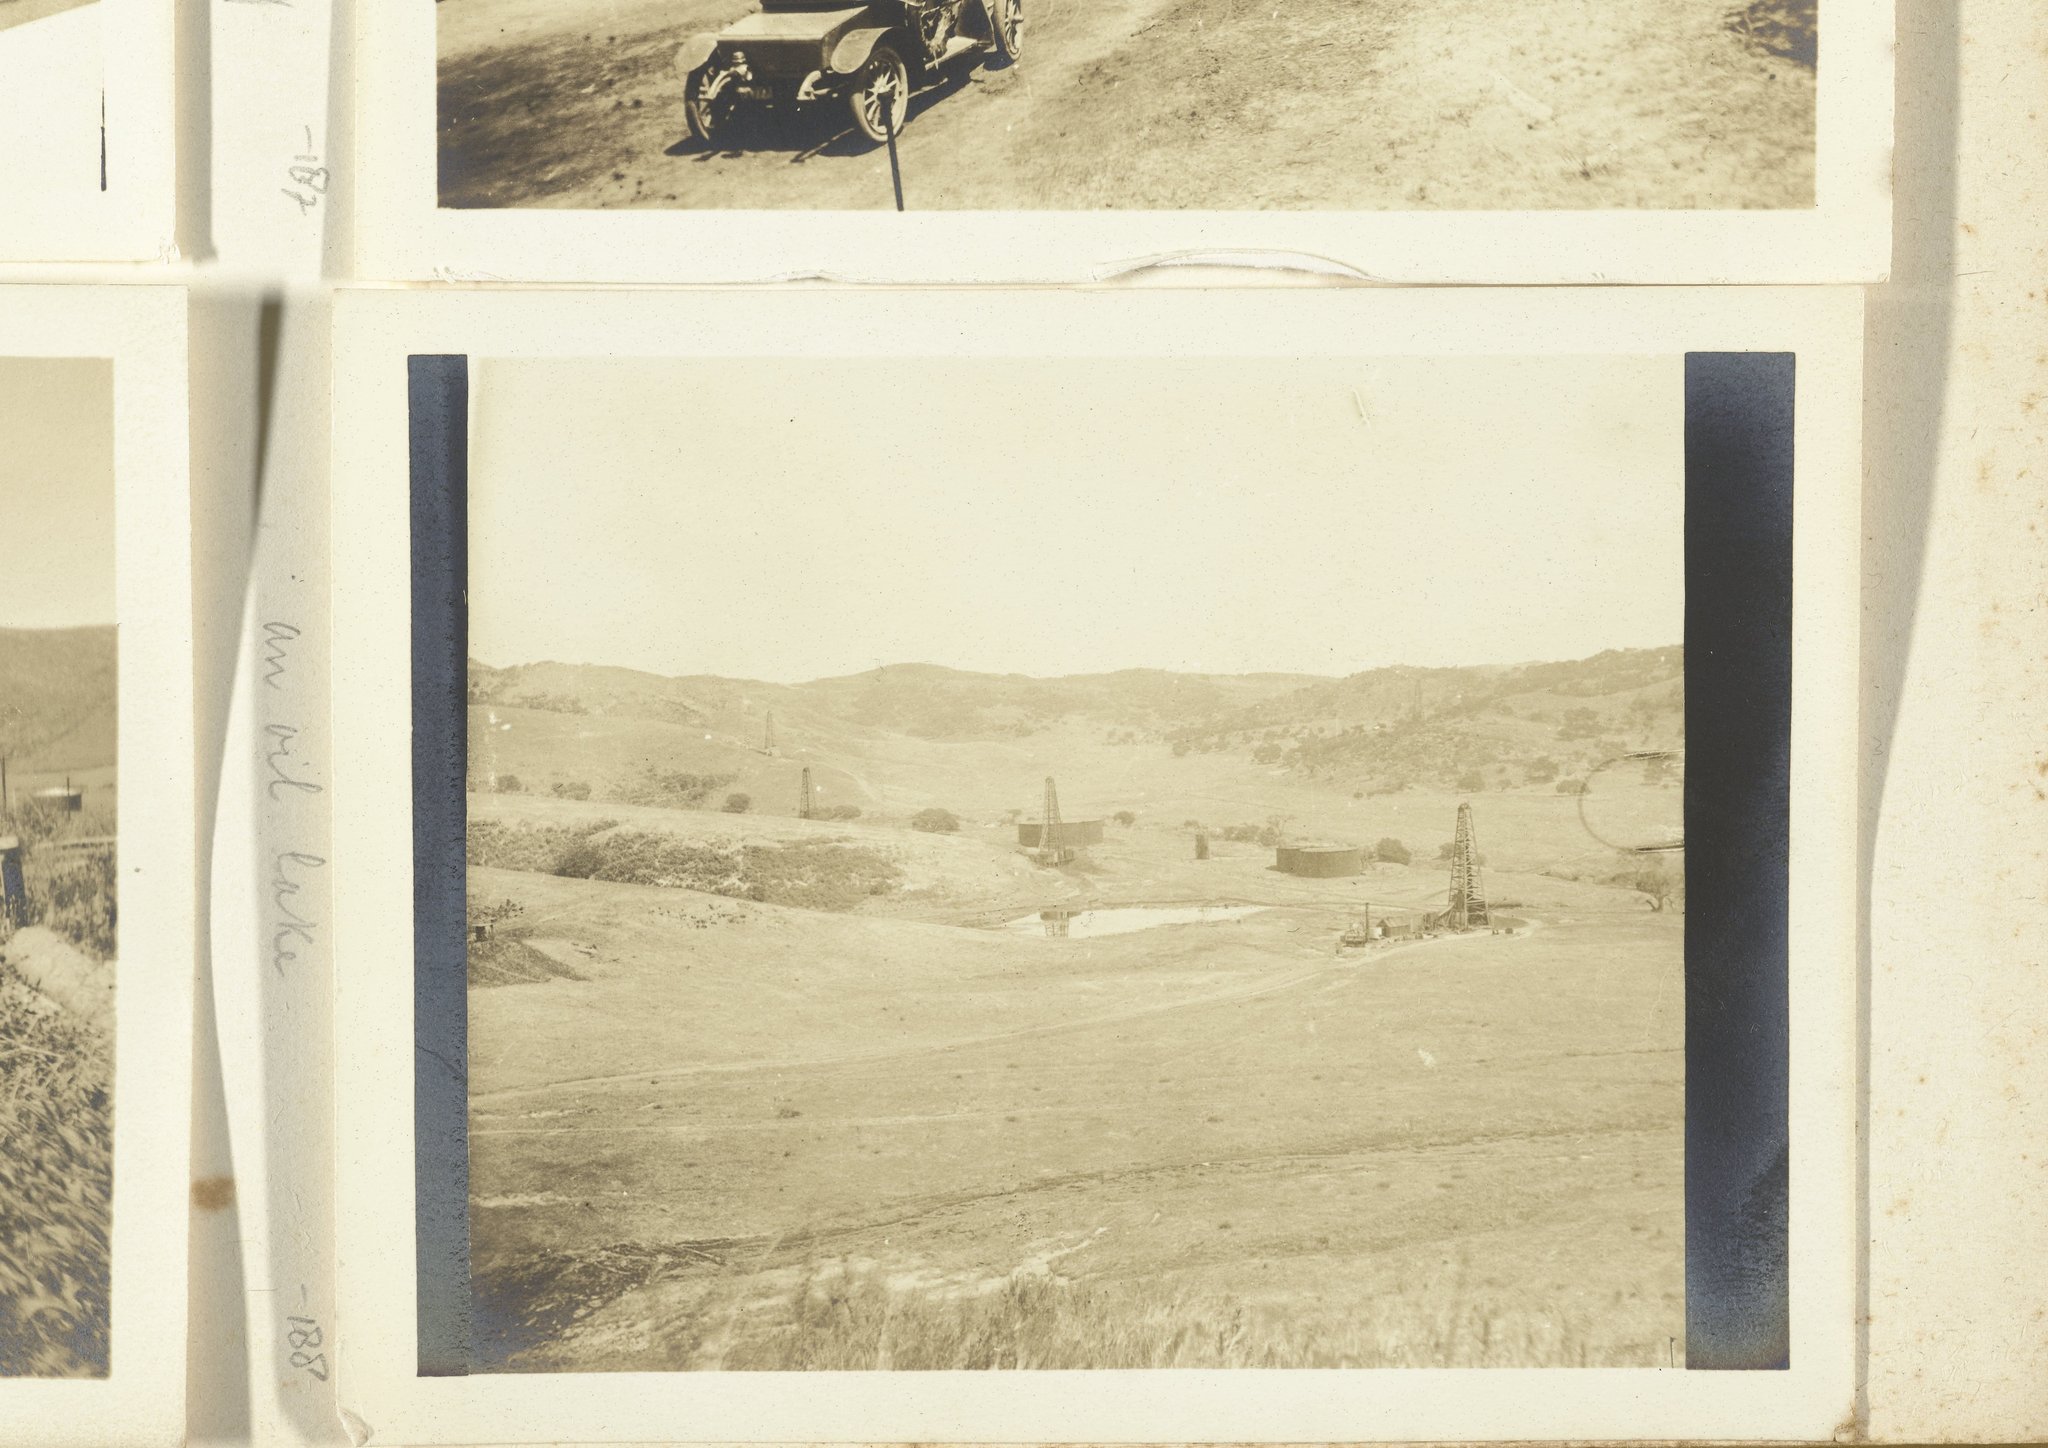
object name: photograph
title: Visit to an Oil Field in Purissima Hills, USA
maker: geldolph adriaan kessler (dolph)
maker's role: fotograaf, industrieel, voetballer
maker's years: 1884-1945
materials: cardboard, photographic support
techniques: gelatin silver print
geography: california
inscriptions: title: ‘An oil lake’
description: In 1908 Kessler accompanied the director of Koninklijke Olie (Royal Dutch Petroleum Company, later Shell), Henri Deterding, as secretary on a world tour. He travelled to Canada and the United States via the Dutch East Indies, Singapore, China, and Japan. Dolph’s photo album contains pictures of an oil field in California, as well as San Francisco’s town hall which had collapsed during an earthquake.